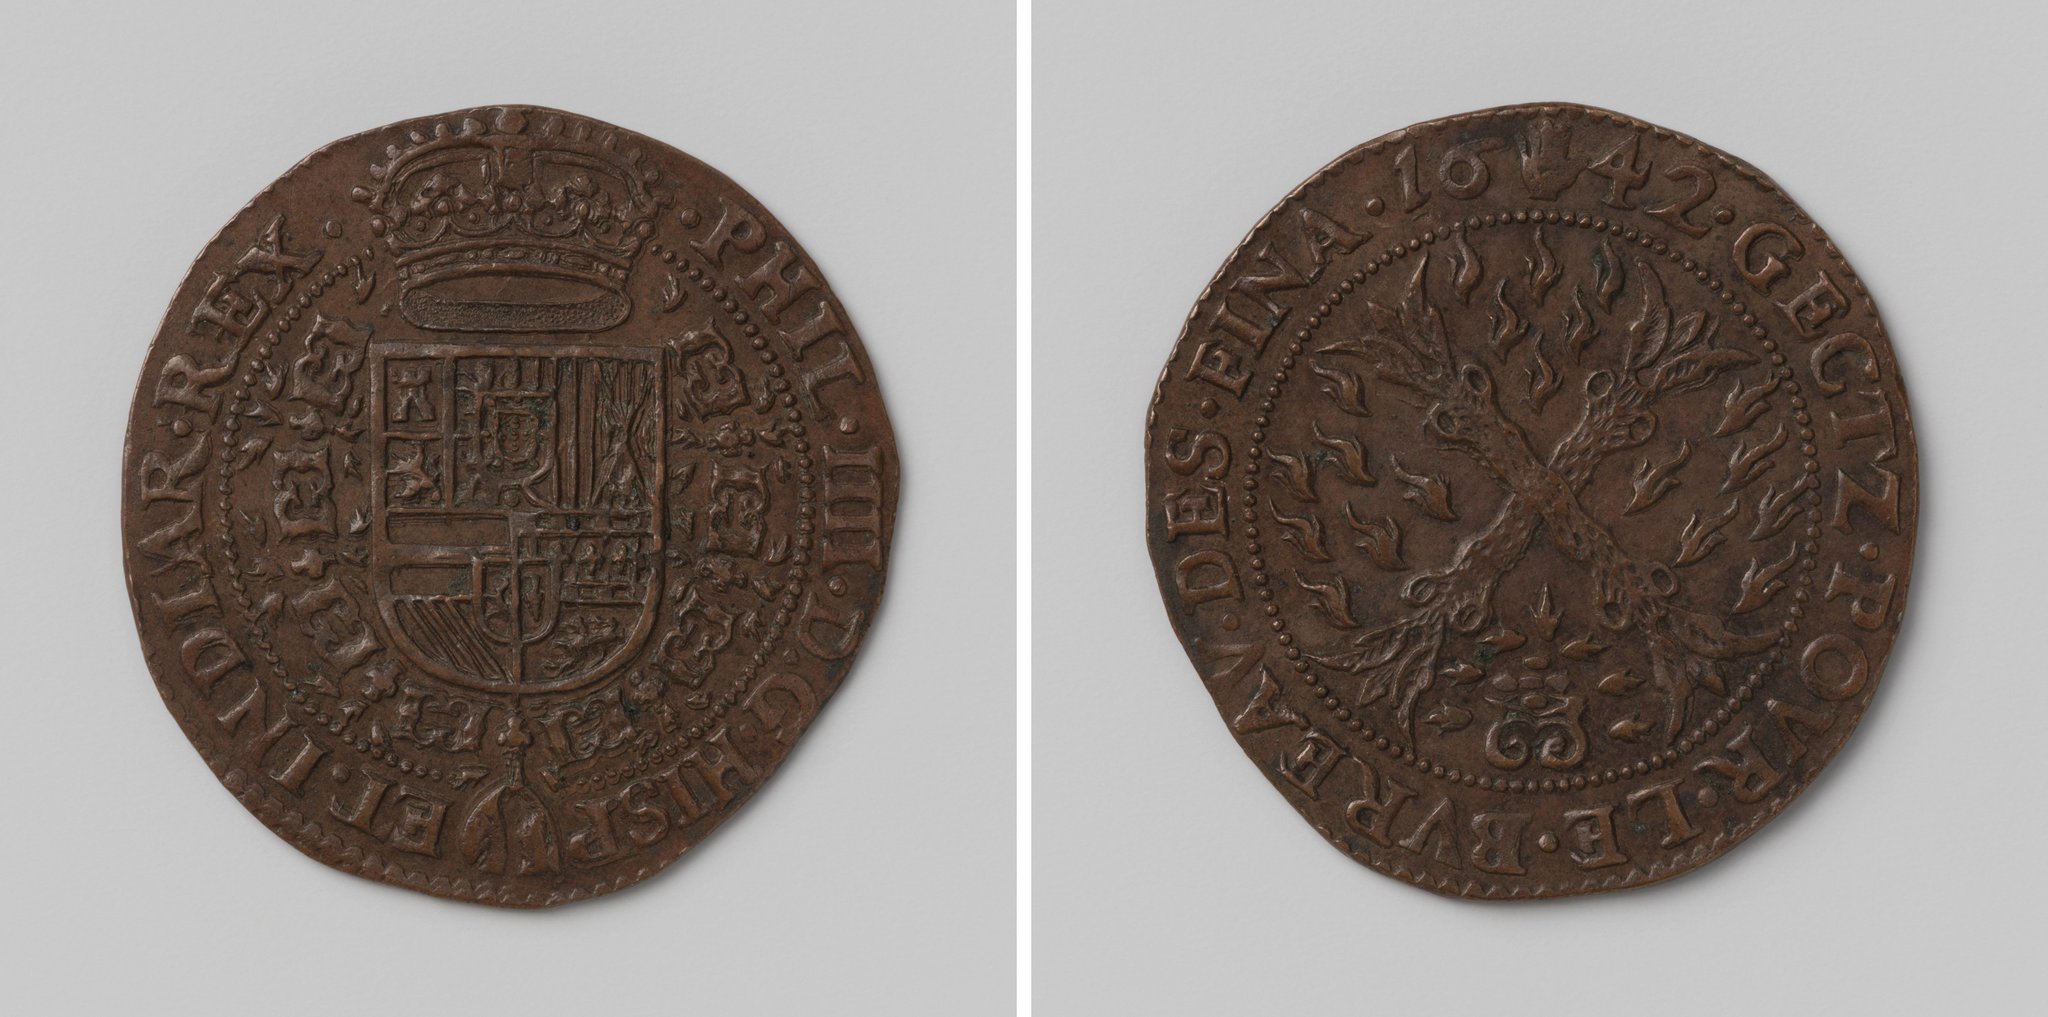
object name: jeton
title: Filips IV, koning van Spanje, rekenpenning geslagen op last van de raad van Financiën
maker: Anonymous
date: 1642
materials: copper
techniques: striking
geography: antwerp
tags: filips iv (koning van spanje)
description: Koperen penning. Voorzijde: gekroond wapenschild, omhangen met de orde van het Gulden Vlies binnen omschrift. Keerzijde: Bourgondisch kruis, omgeven door vonken; daaronder: vuurslag, waar vonken uitschieten binnen omschrift